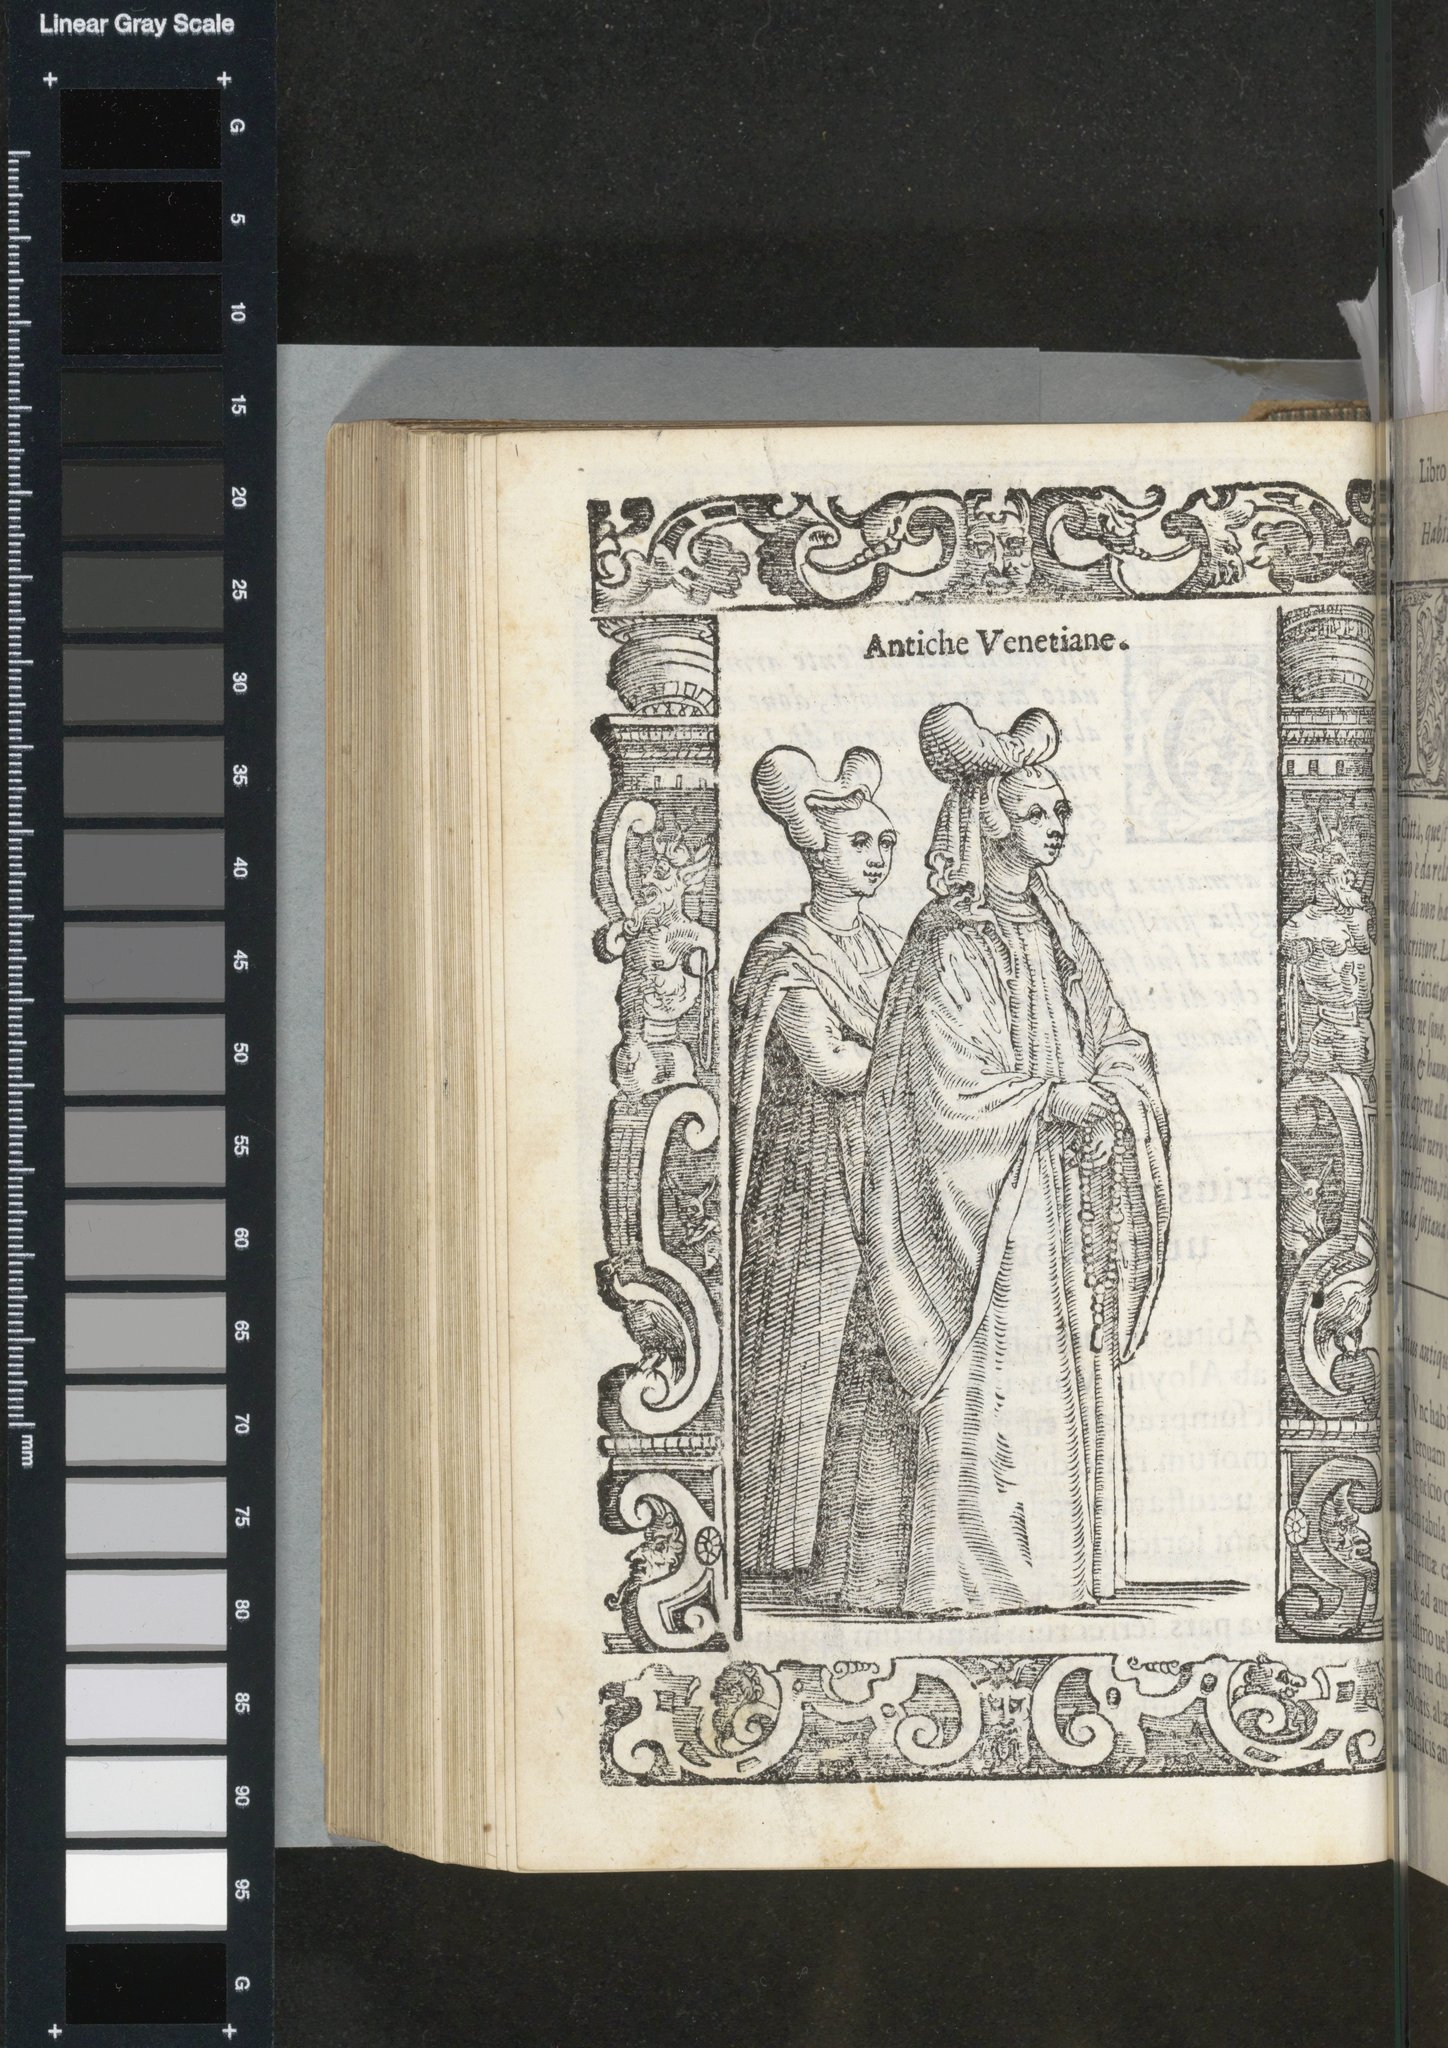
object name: costume print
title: Antiche venetiane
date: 1598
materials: paper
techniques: woodcut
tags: fashion plates